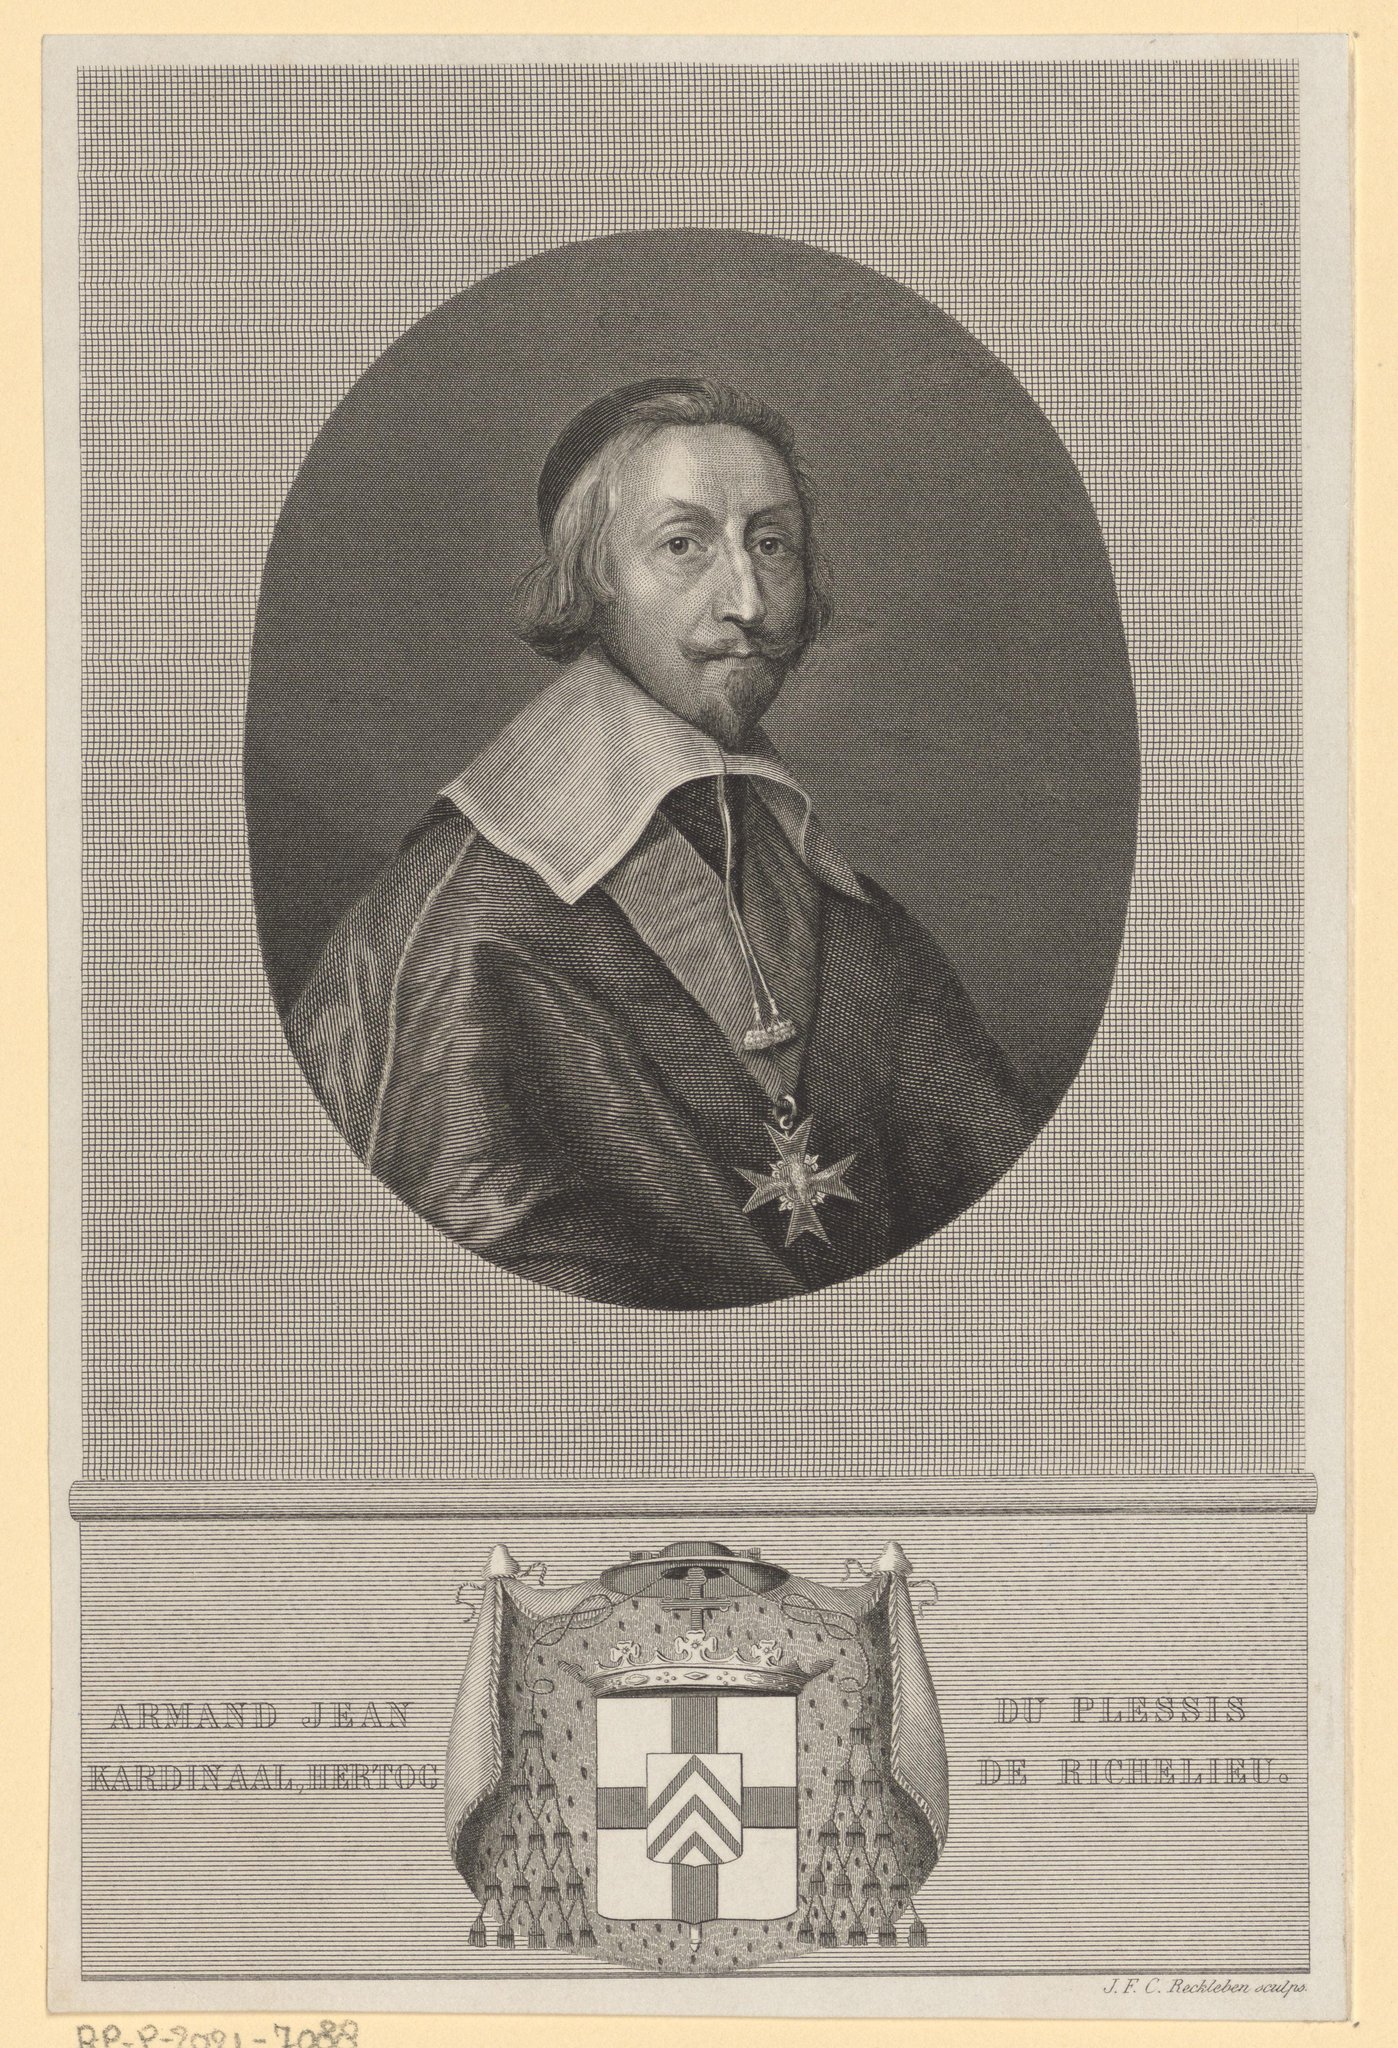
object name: print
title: Portret van Armand-Jean du Plessis hertog van Richelieu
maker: jan frederik christiaan reckleben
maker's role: print maker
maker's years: 1819-1879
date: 1841-1879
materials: paper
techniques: engraving, etching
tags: paris, armand-jean du plessis hertog van richelieu, historical persons, armorial bearing, heraldry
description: Prent mogelijk uit: Arend, Johannes Pieter. Algemeene geschiedenis des vaderlands van de vroegste tijden tot op heden (...). Amsterdam: C.L. Schleijer & Zoon, 1841-1879.